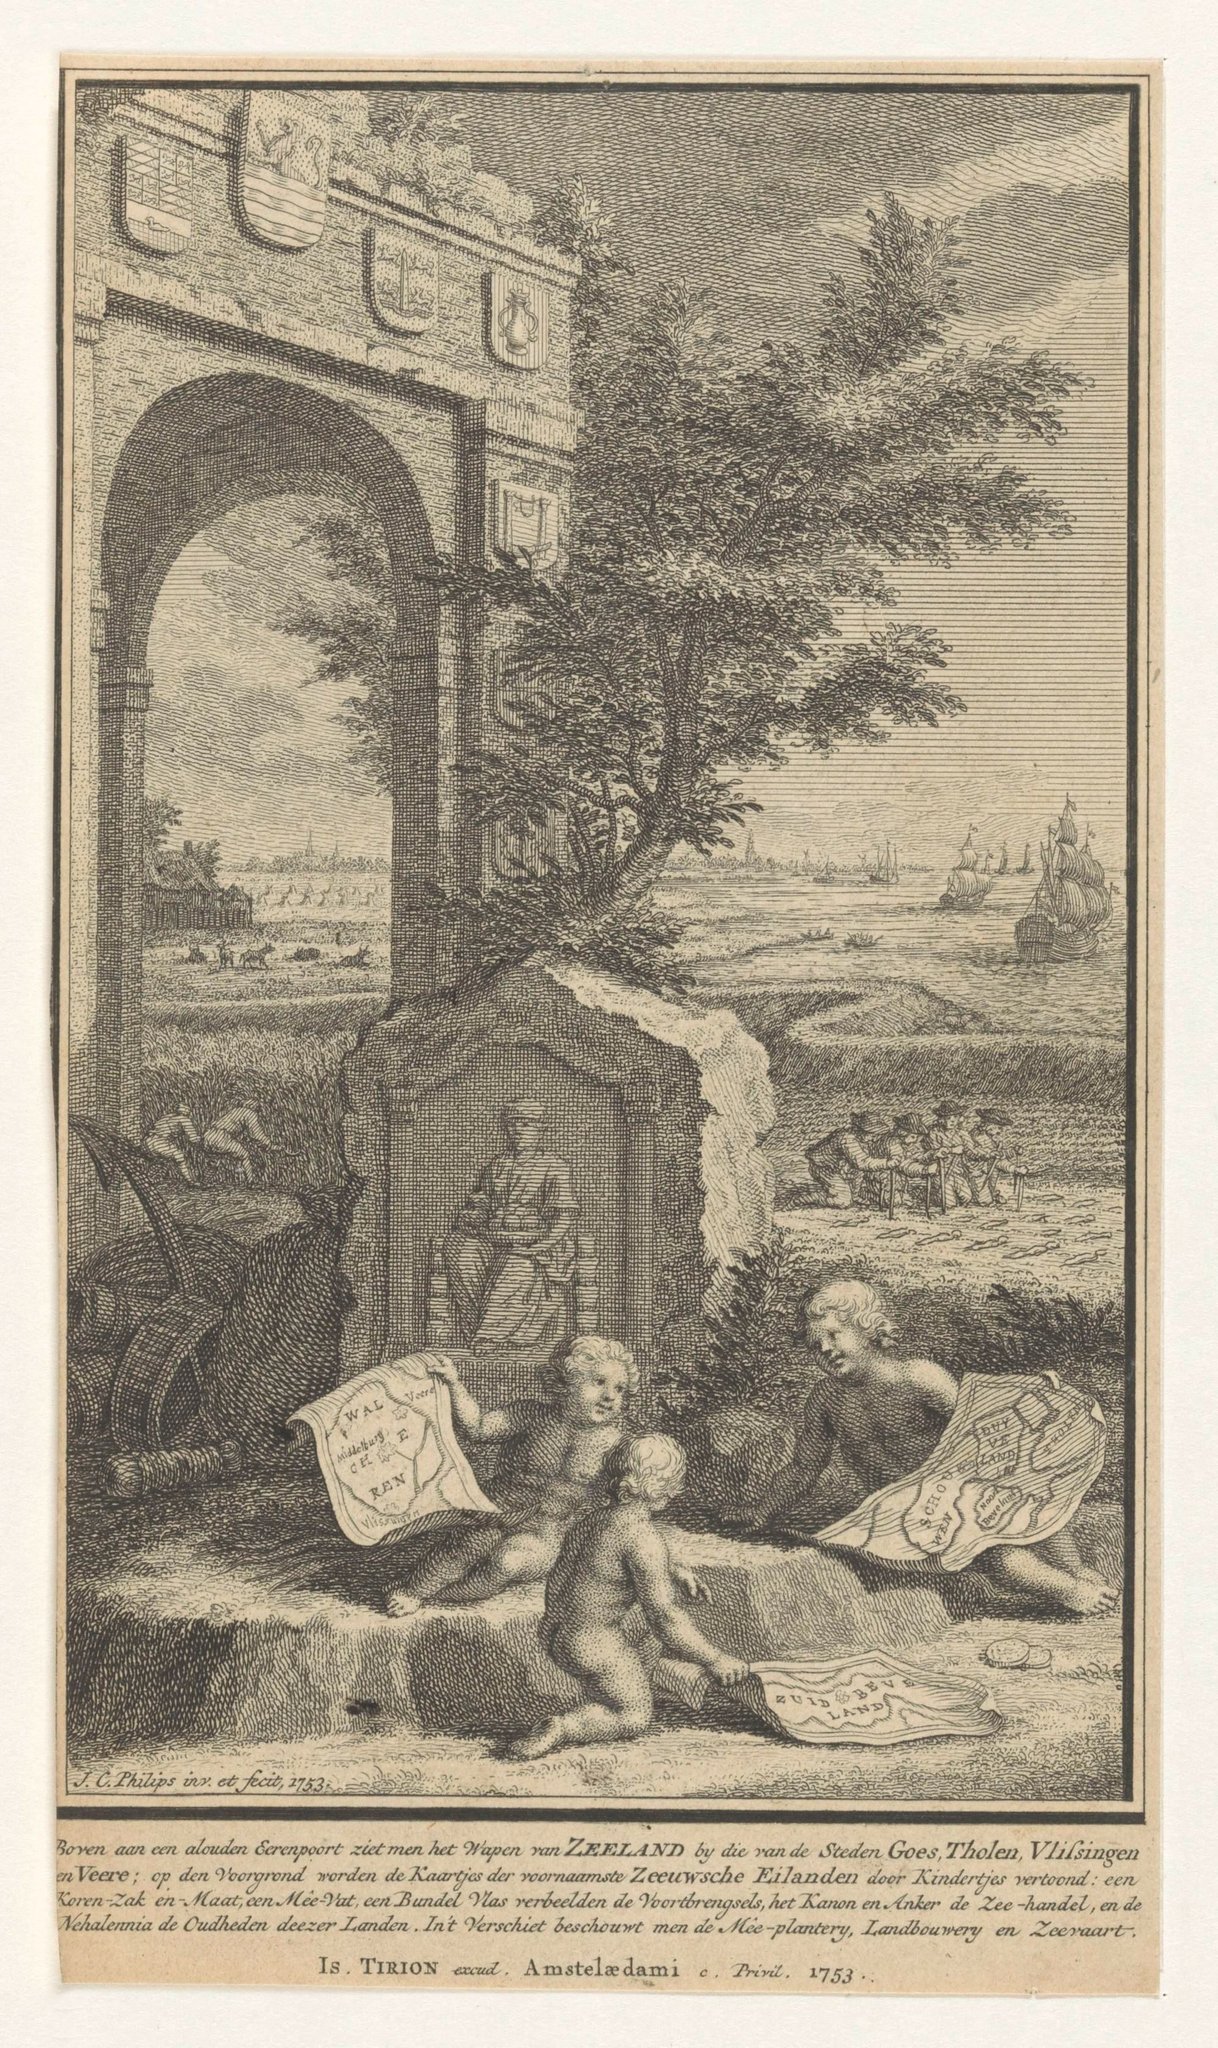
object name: print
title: Allegorie op de provincie Zeeland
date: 1753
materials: paper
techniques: engraving, etching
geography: amsterdam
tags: maps, atlases, triumphal arch, coat of arms (as symbol of the state, etc.) (+ province; provincial), zeeland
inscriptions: collector's mark: Lugt 2228, collector's mark: Lugt 2760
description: Titelpagina voor: Salmon, Thomas en Wagenaar, Jan. Tegenwoordige staat der Vereenigde Nederlanden, Tiende deel. Amsterdam: Tirion, Isaak, 1753. / Titelpagina voor: Salmon, Thomas. Hedendaagsche historie of tegenwoordige staat van alle volkeren, XXde deel. Amsterdam: Tirion, Isaak, 1753. Tussen 1739 en 1804 verscheen bij de Amsterdamse uitgever Isaak Tirion een serie van 23 delen ‘Tegenwoordige staat der Vereenigde Nederlanden’, een verzamelwerk voor een groot deel van de hand van Jan Wagenaar. Deze 23 delen waren een onderdeel van een veel groter werk, de ‘Hedendaagsche historie of tegenwoordige staat van alle volkeren’, waarvan het eerste deel in 1729 was verschenen. Beide series hebben een eigen nummering: de delen 1 t/m 23 van de serie over de Vereenigde Nederlanden zijn genummerd 11 t/m 33 van de Tegenwoordige staat van alle volkeren.